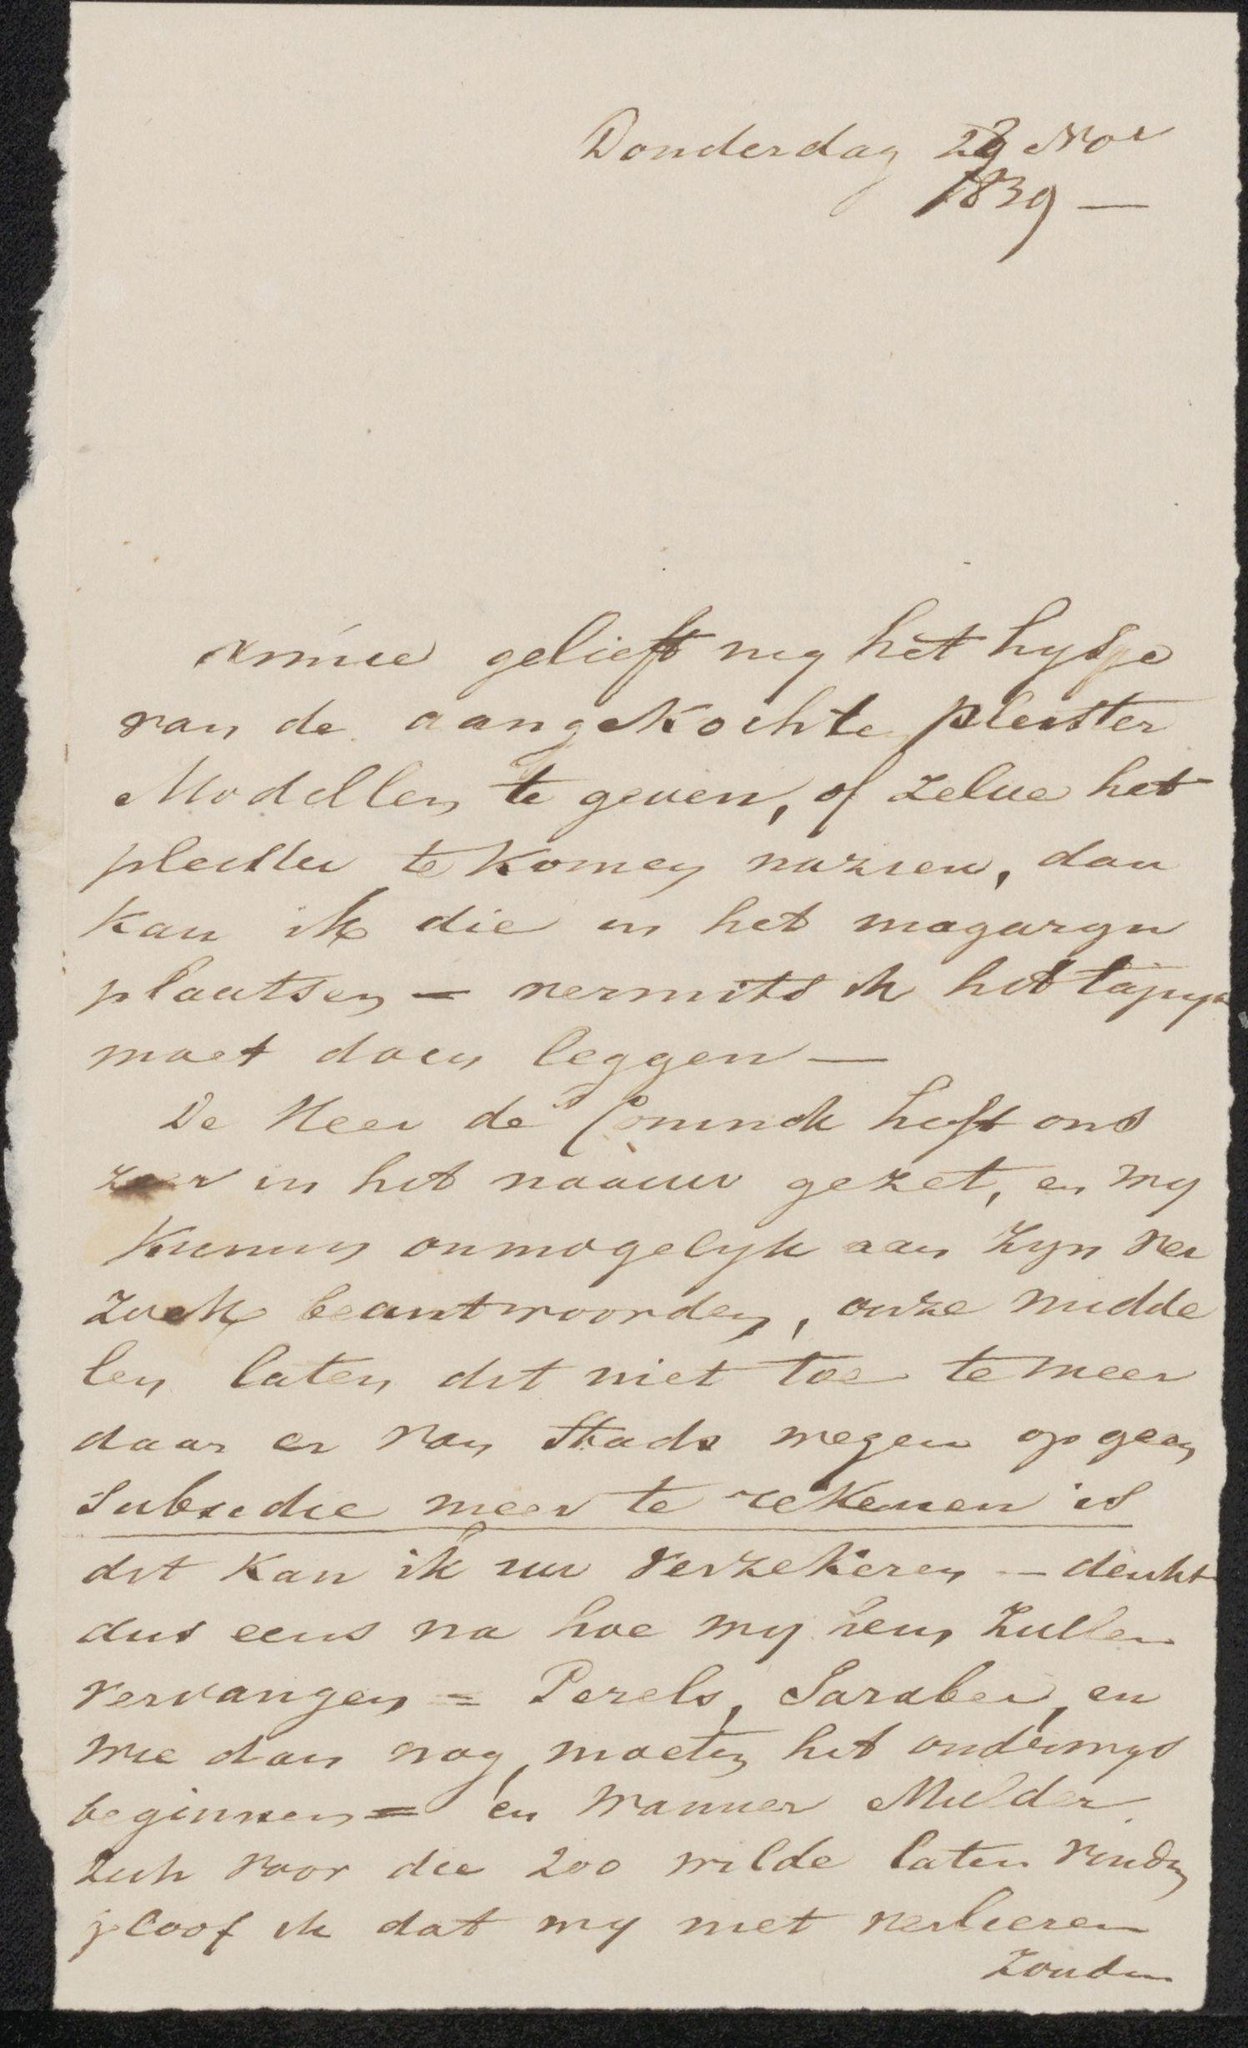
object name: letter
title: Brief aan anoniem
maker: zeger reijers (architect)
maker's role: architect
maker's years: 1789-1857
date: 1839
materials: ink, paper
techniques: pen, writing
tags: sculpture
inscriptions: watermark